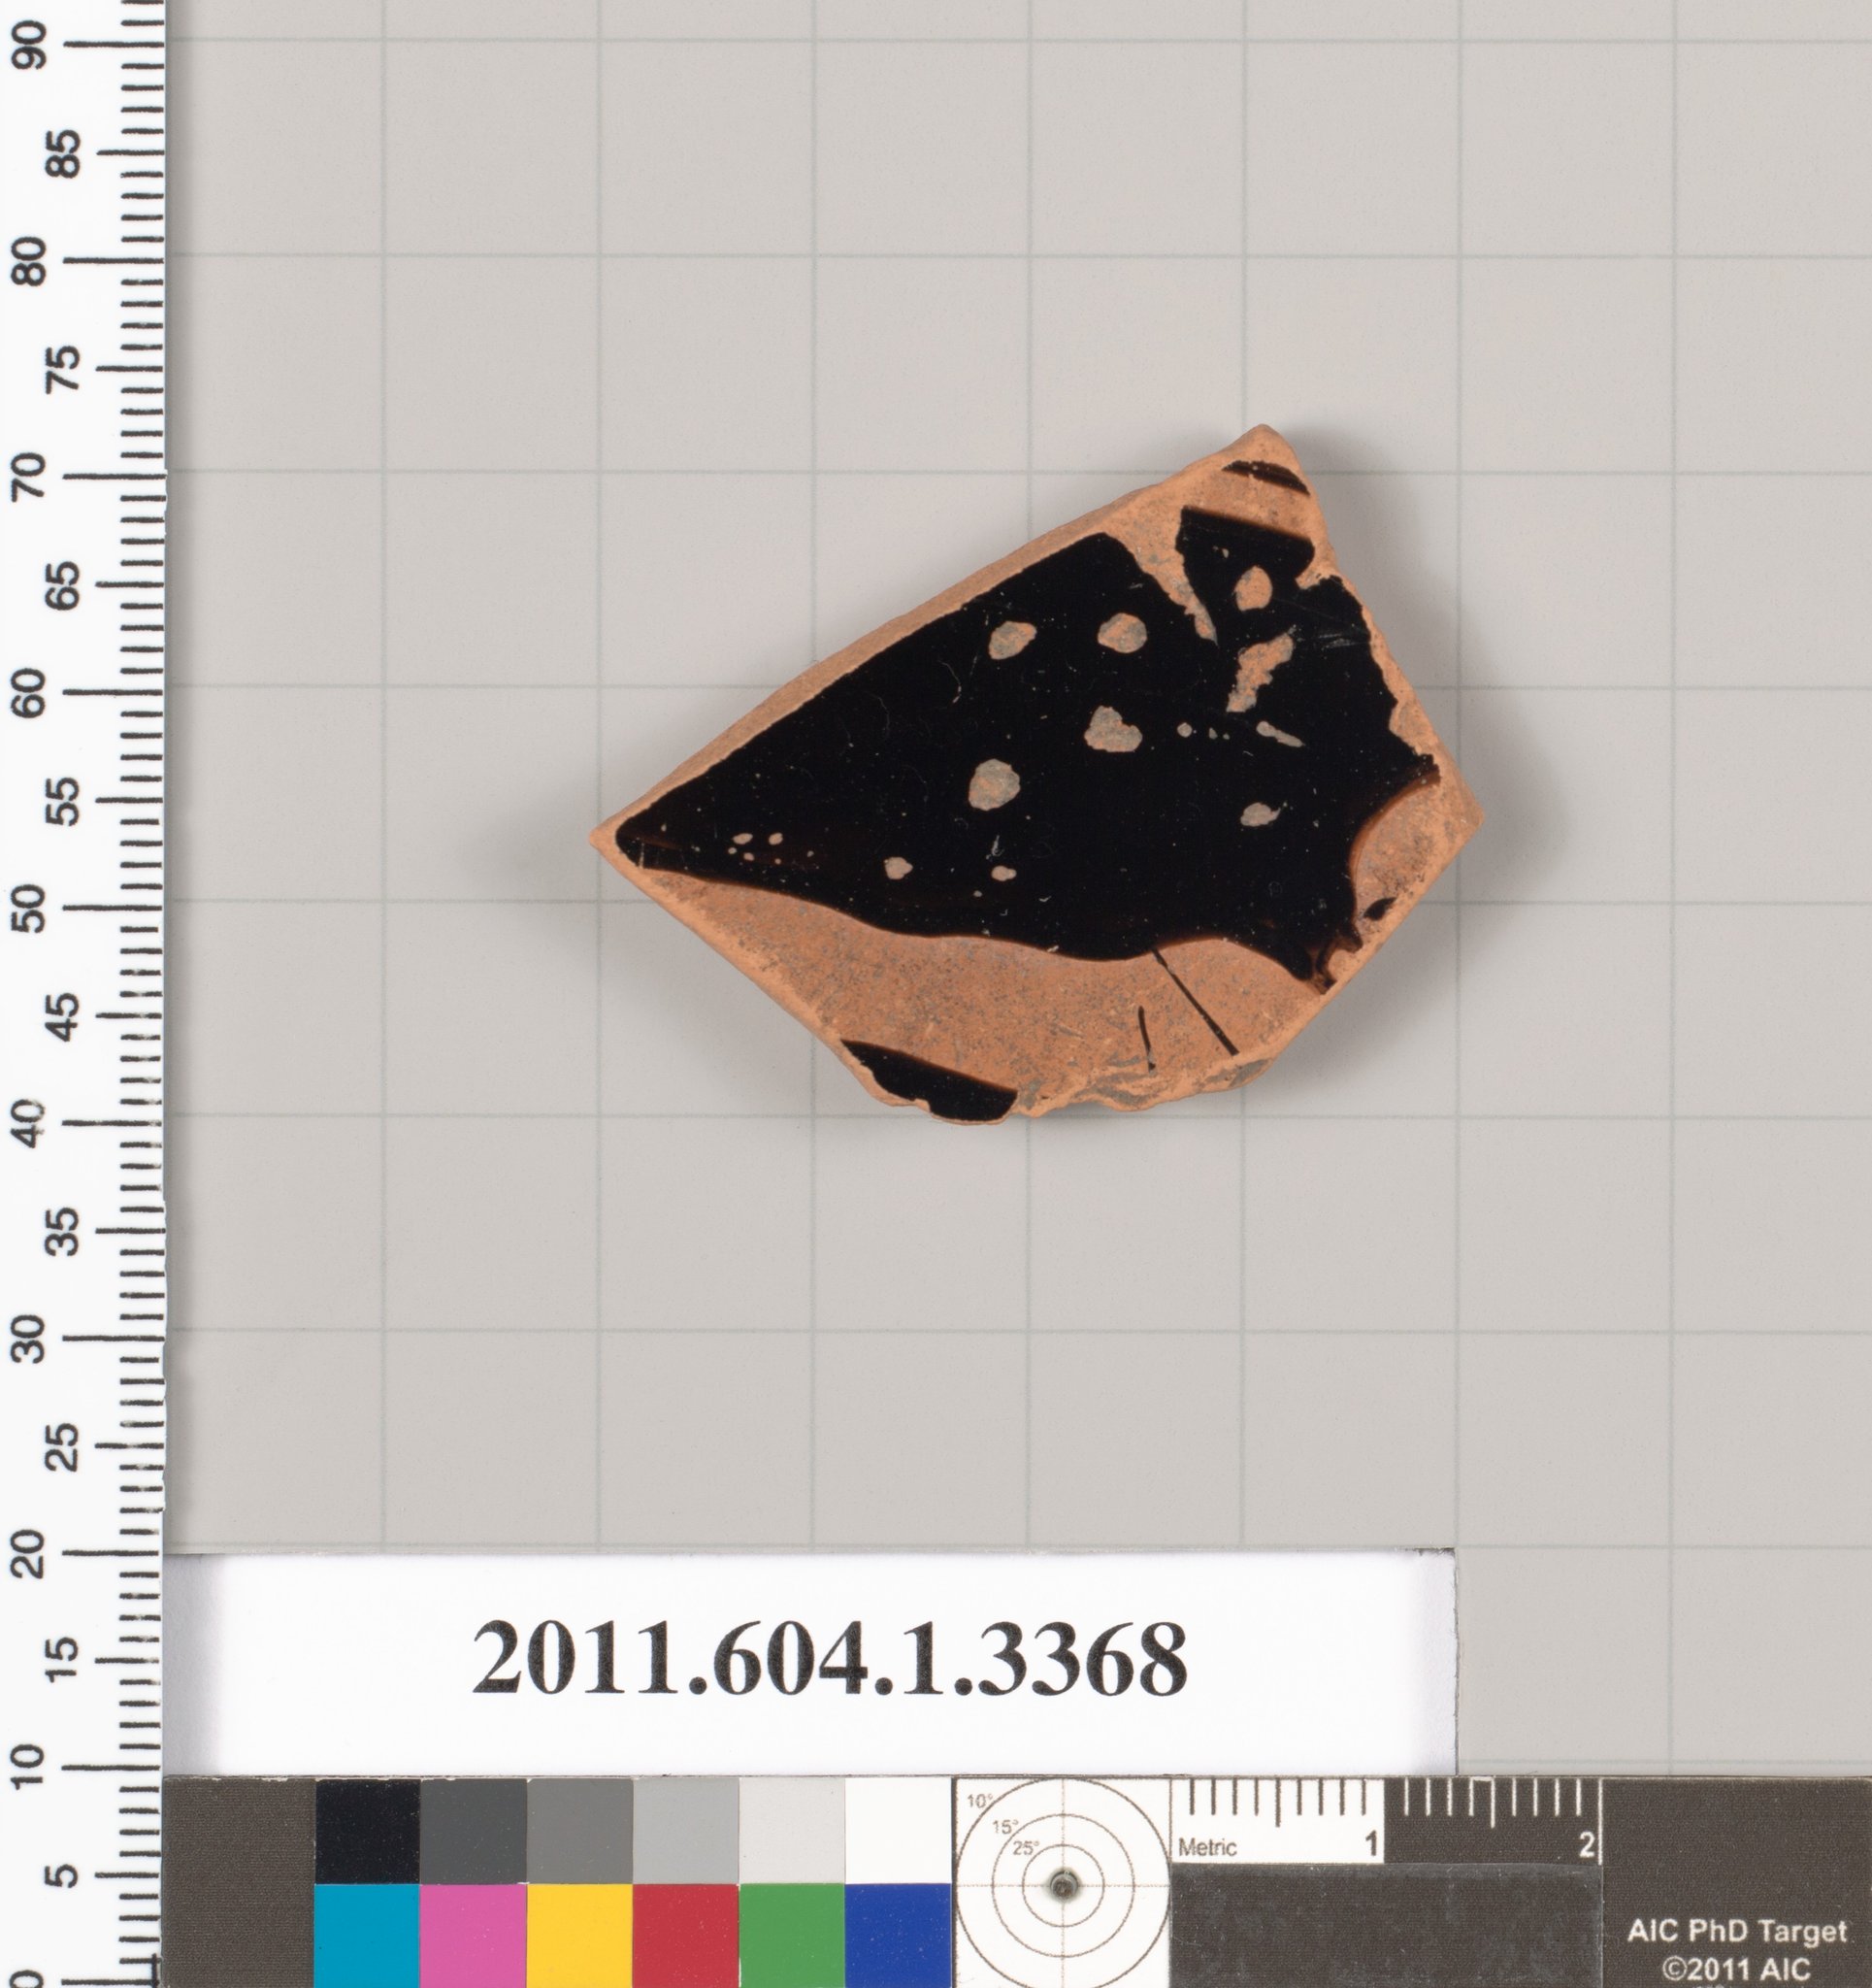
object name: kylix fragment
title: Terracotta fragment of a kylix (drinking cup)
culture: greek, attic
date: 475-451 BCE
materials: terracotta